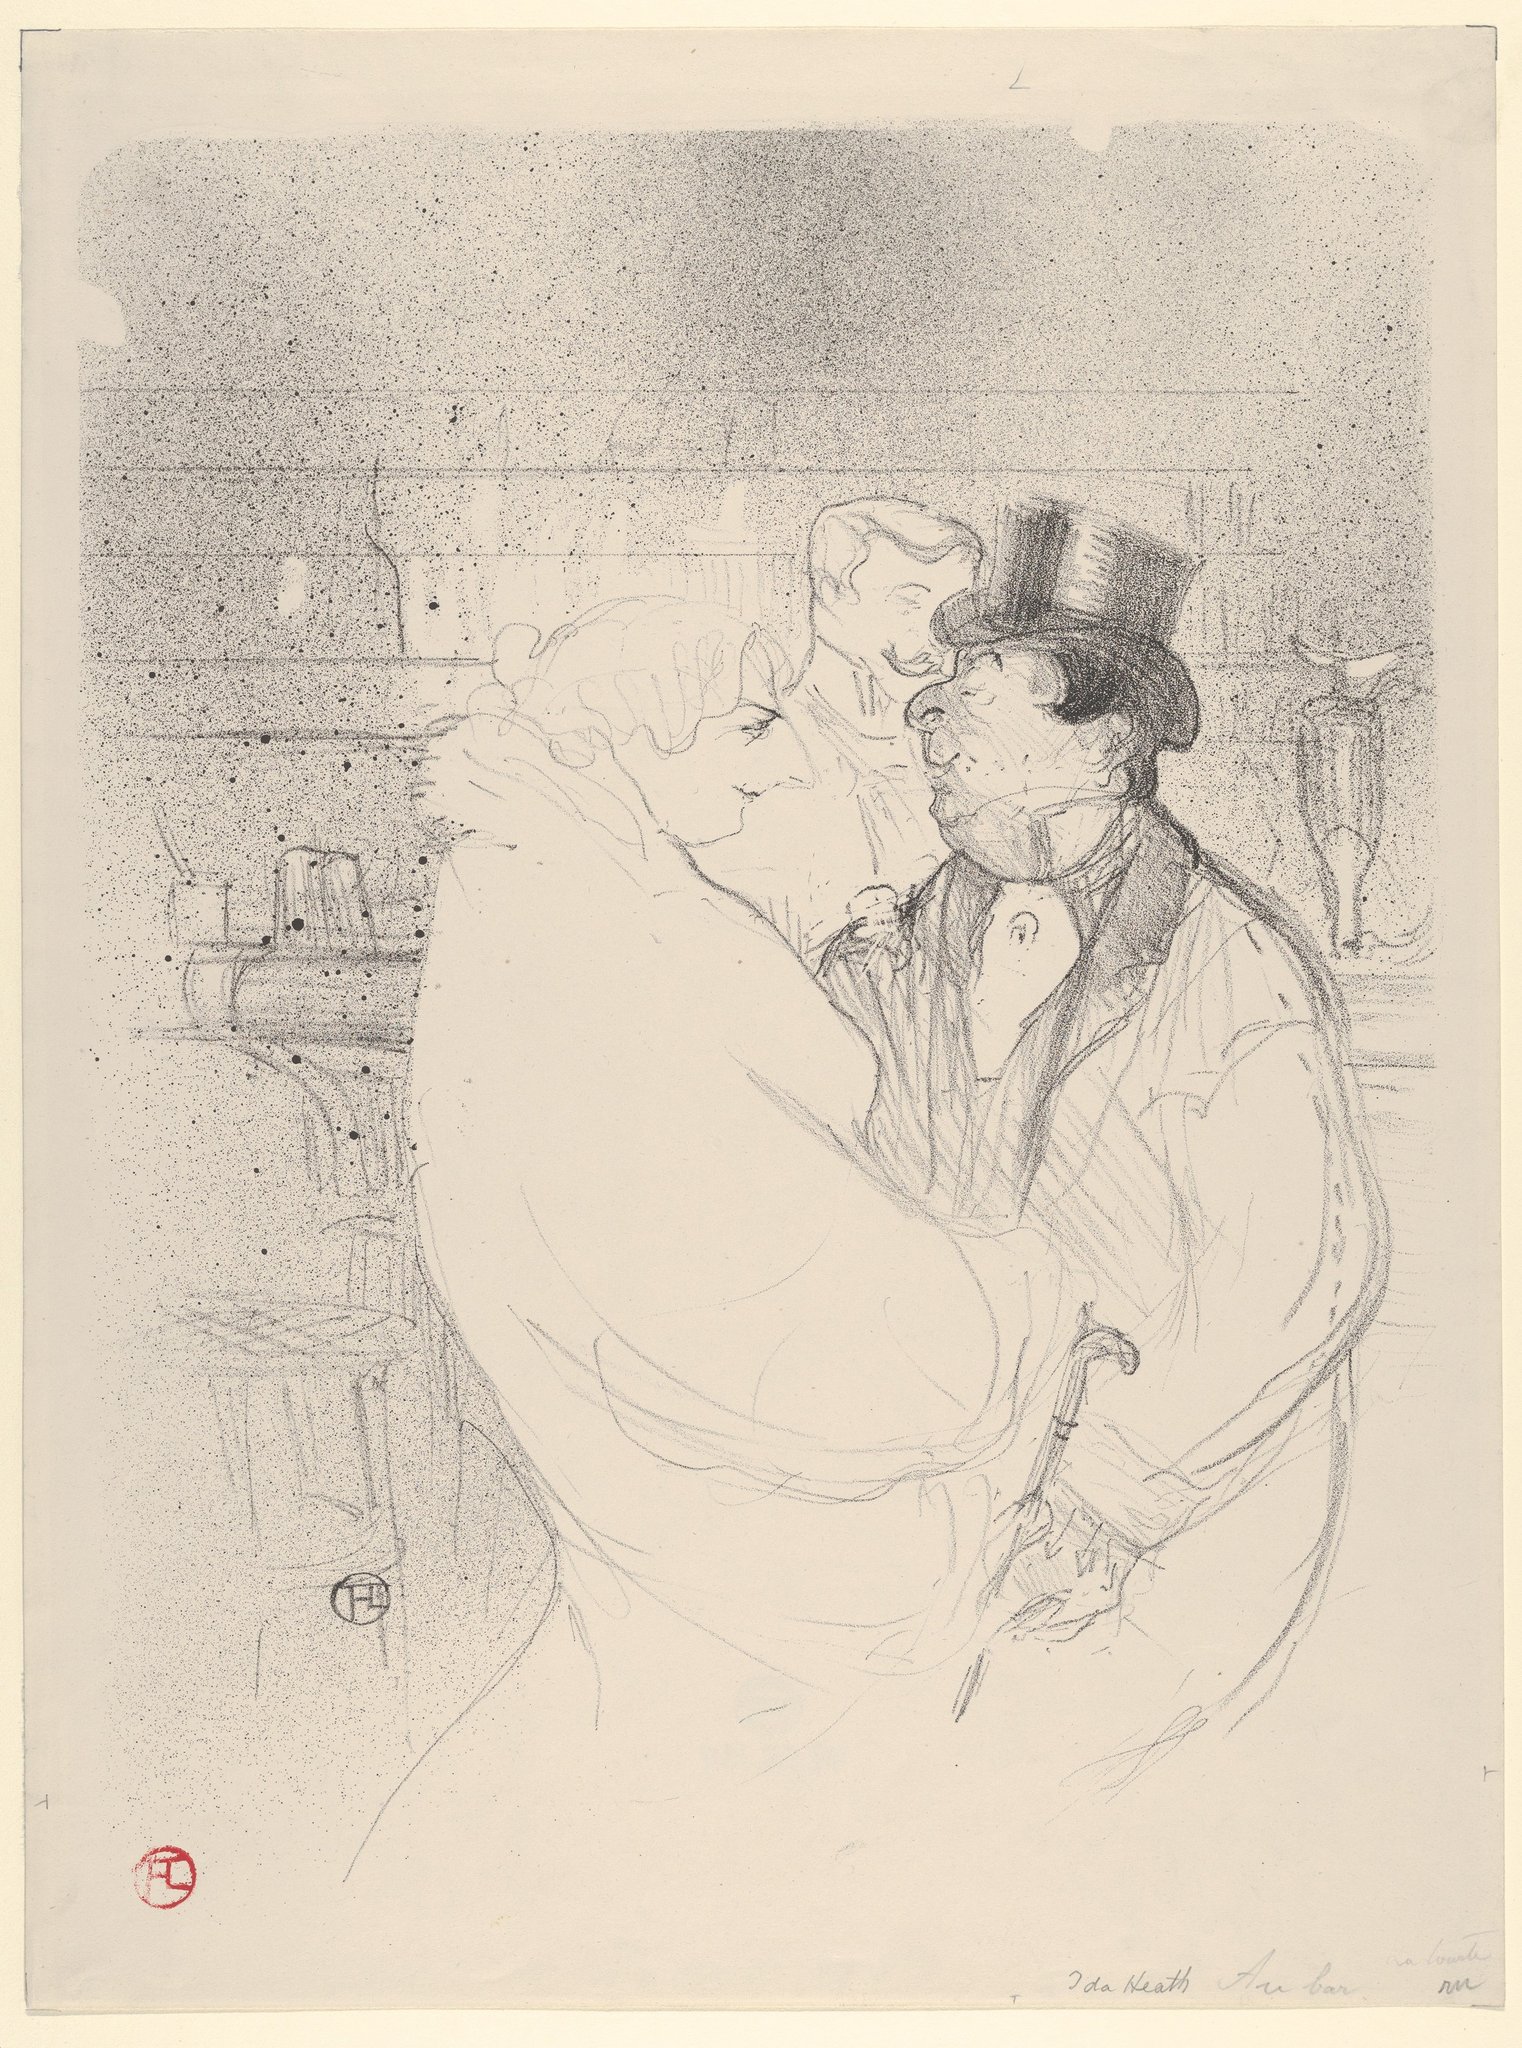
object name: print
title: Ida Heath at the Bar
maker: henri de toulouse-lautrec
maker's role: artist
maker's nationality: french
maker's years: 1864-1901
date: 1894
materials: crayon, ink, paper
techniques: brush, lithograph, printing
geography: france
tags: men,women